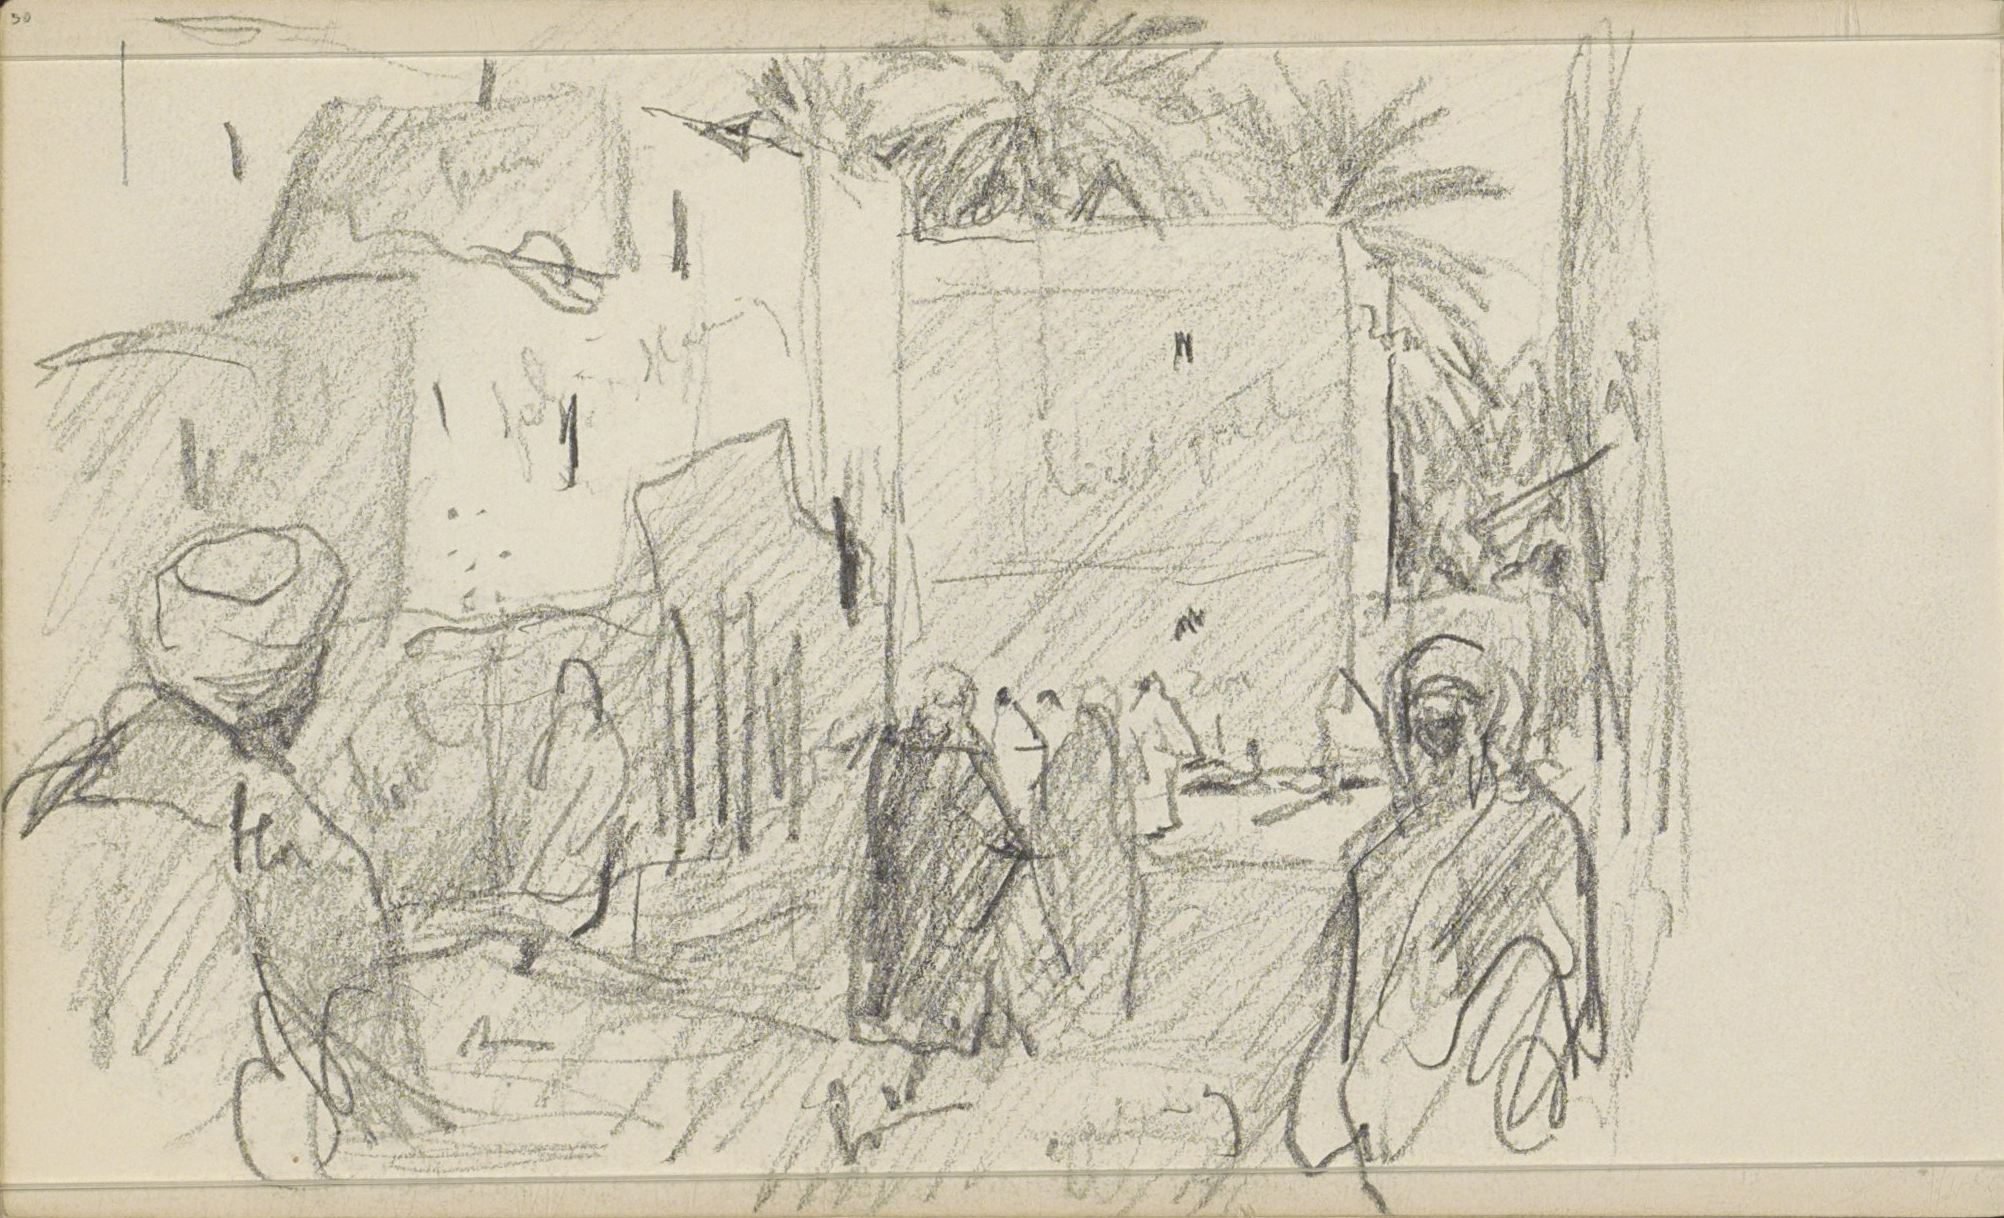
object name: sketchbook leaf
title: Straat met figuren in Biskra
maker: marius bauer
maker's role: draughtsman, print maker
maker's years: 1867-1932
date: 1922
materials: paper, pencil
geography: biskra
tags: africans, street (+ city(-scape) with figures, staffage)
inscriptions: kleurnotitie, handgeschreven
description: Pagina 50 uit een schetsboek met 31 bladen.